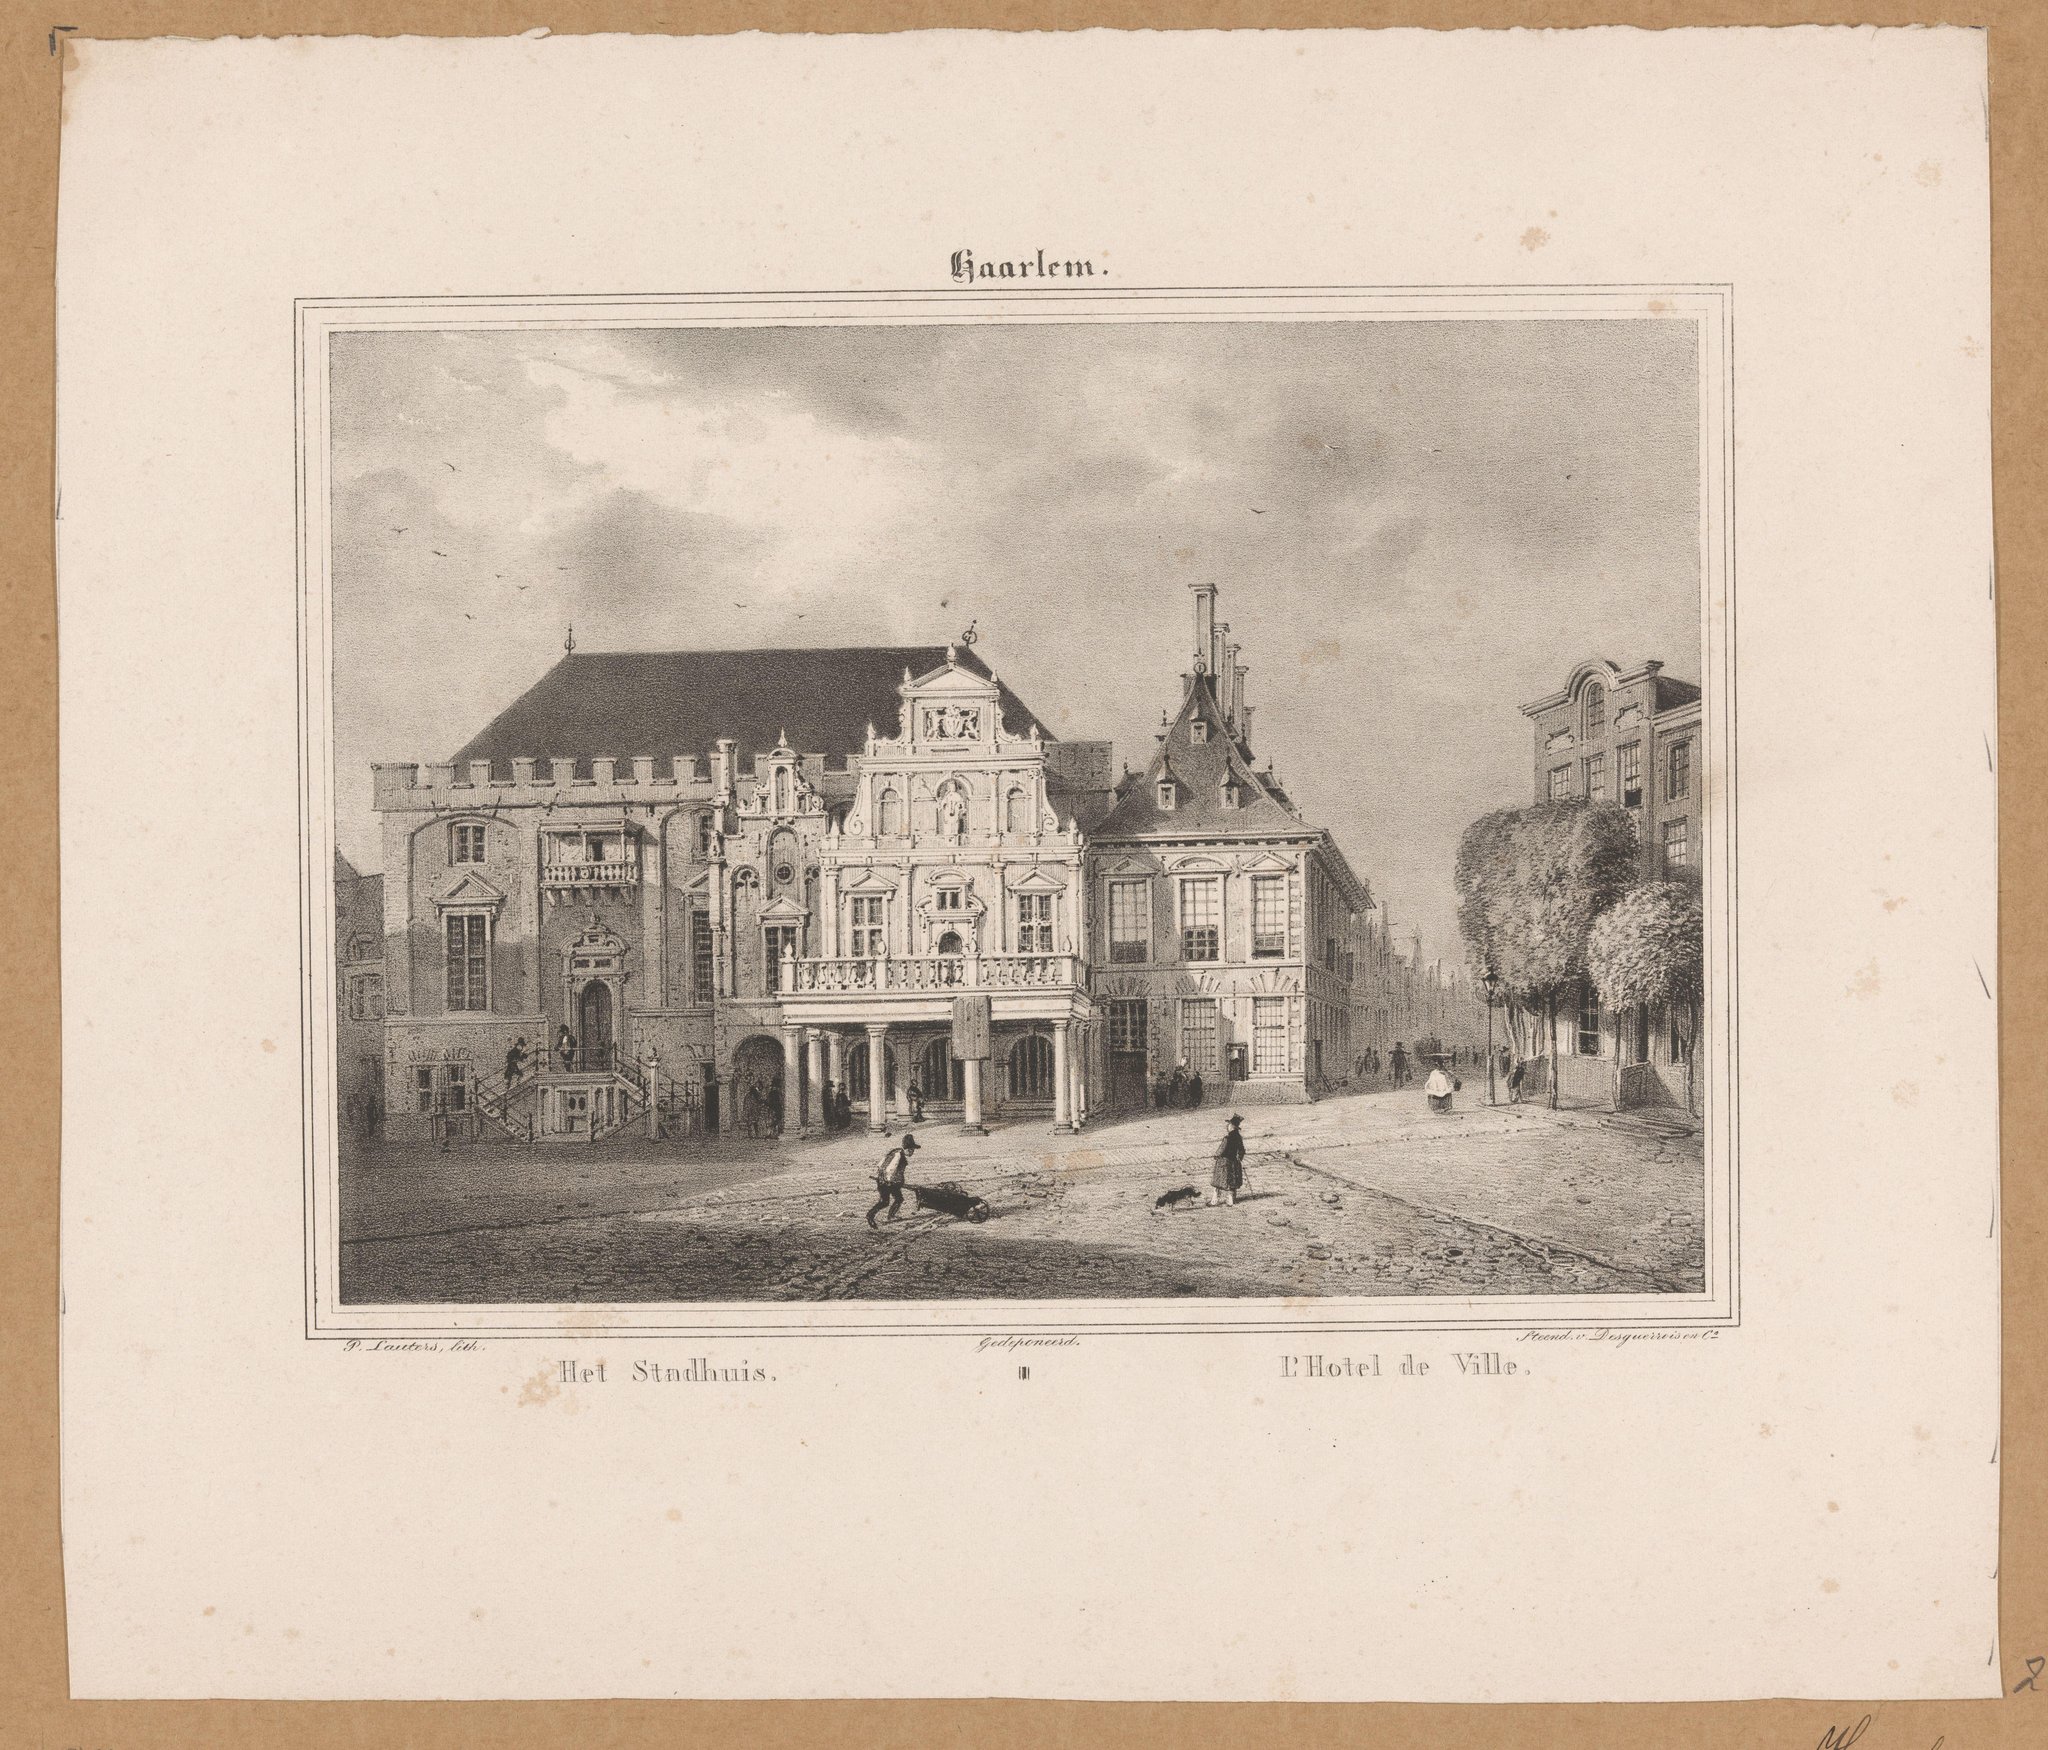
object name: print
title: Gezicht op het Stadhuis aan de Grote Markt in Haarlem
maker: paulus lauters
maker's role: print maker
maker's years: 1806-1875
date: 1827-1900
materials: paper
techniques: lithograph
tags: townhall, edifice, e.g.: public building, department store